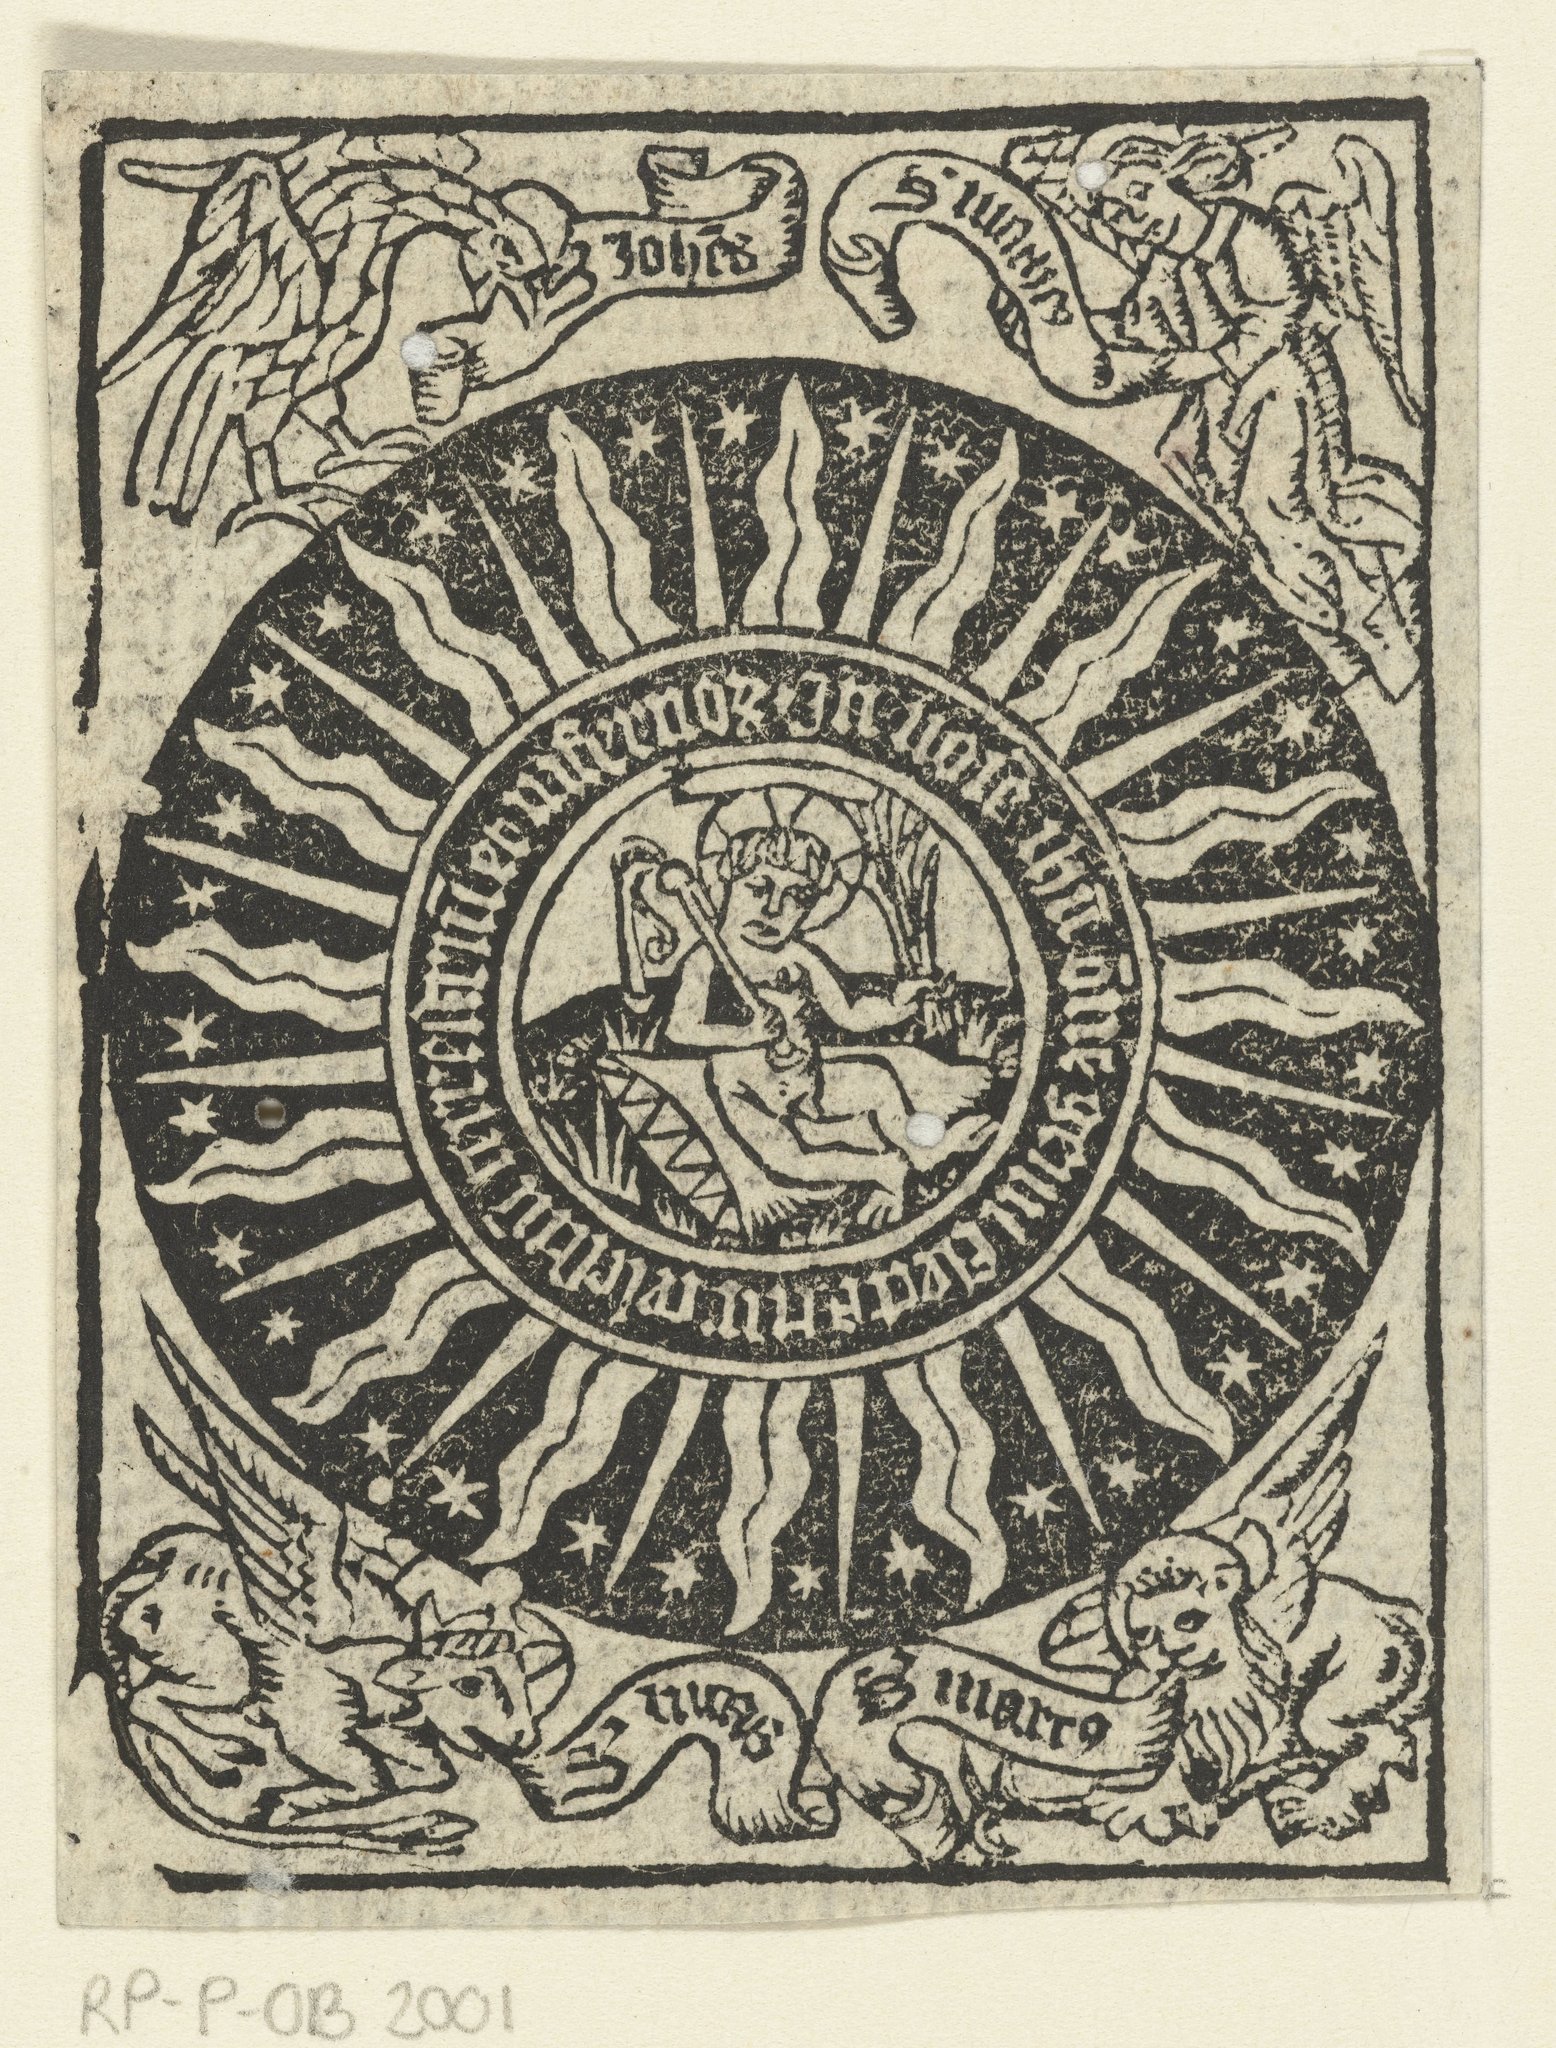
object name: book illustration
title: Het Christuskind kastijdt zichzelf.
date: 1480-1500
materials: paper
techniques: woodcut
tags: the four symbols of the evangelists, 'the apocalyptic beasts', self-castigation ~ ascetic life, christ as youth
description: Eén blad van 113 uit Ludolphus de Saxonia, "Dit es dleué ons liefs heeren ihesu christi". Anonieme Nederlandse vertaling. Uitgegeven door Henrick Eckert van Homberch te Antwerpen in 1503. Botke, K. Deze 113 houtsneden, die meestal reeds in vroege Nederlandse boeken gebruikt zijn, worden toegeschreven aan de tweede Meester van Delft, de Meester van de Delbecq-Schreiber-passie en de Meester van de Virgo inter Virgines. In Conway (1884) en in "De gulden passer"(1951) zijn tevens eerdere versies opgenomen. Botke, K.